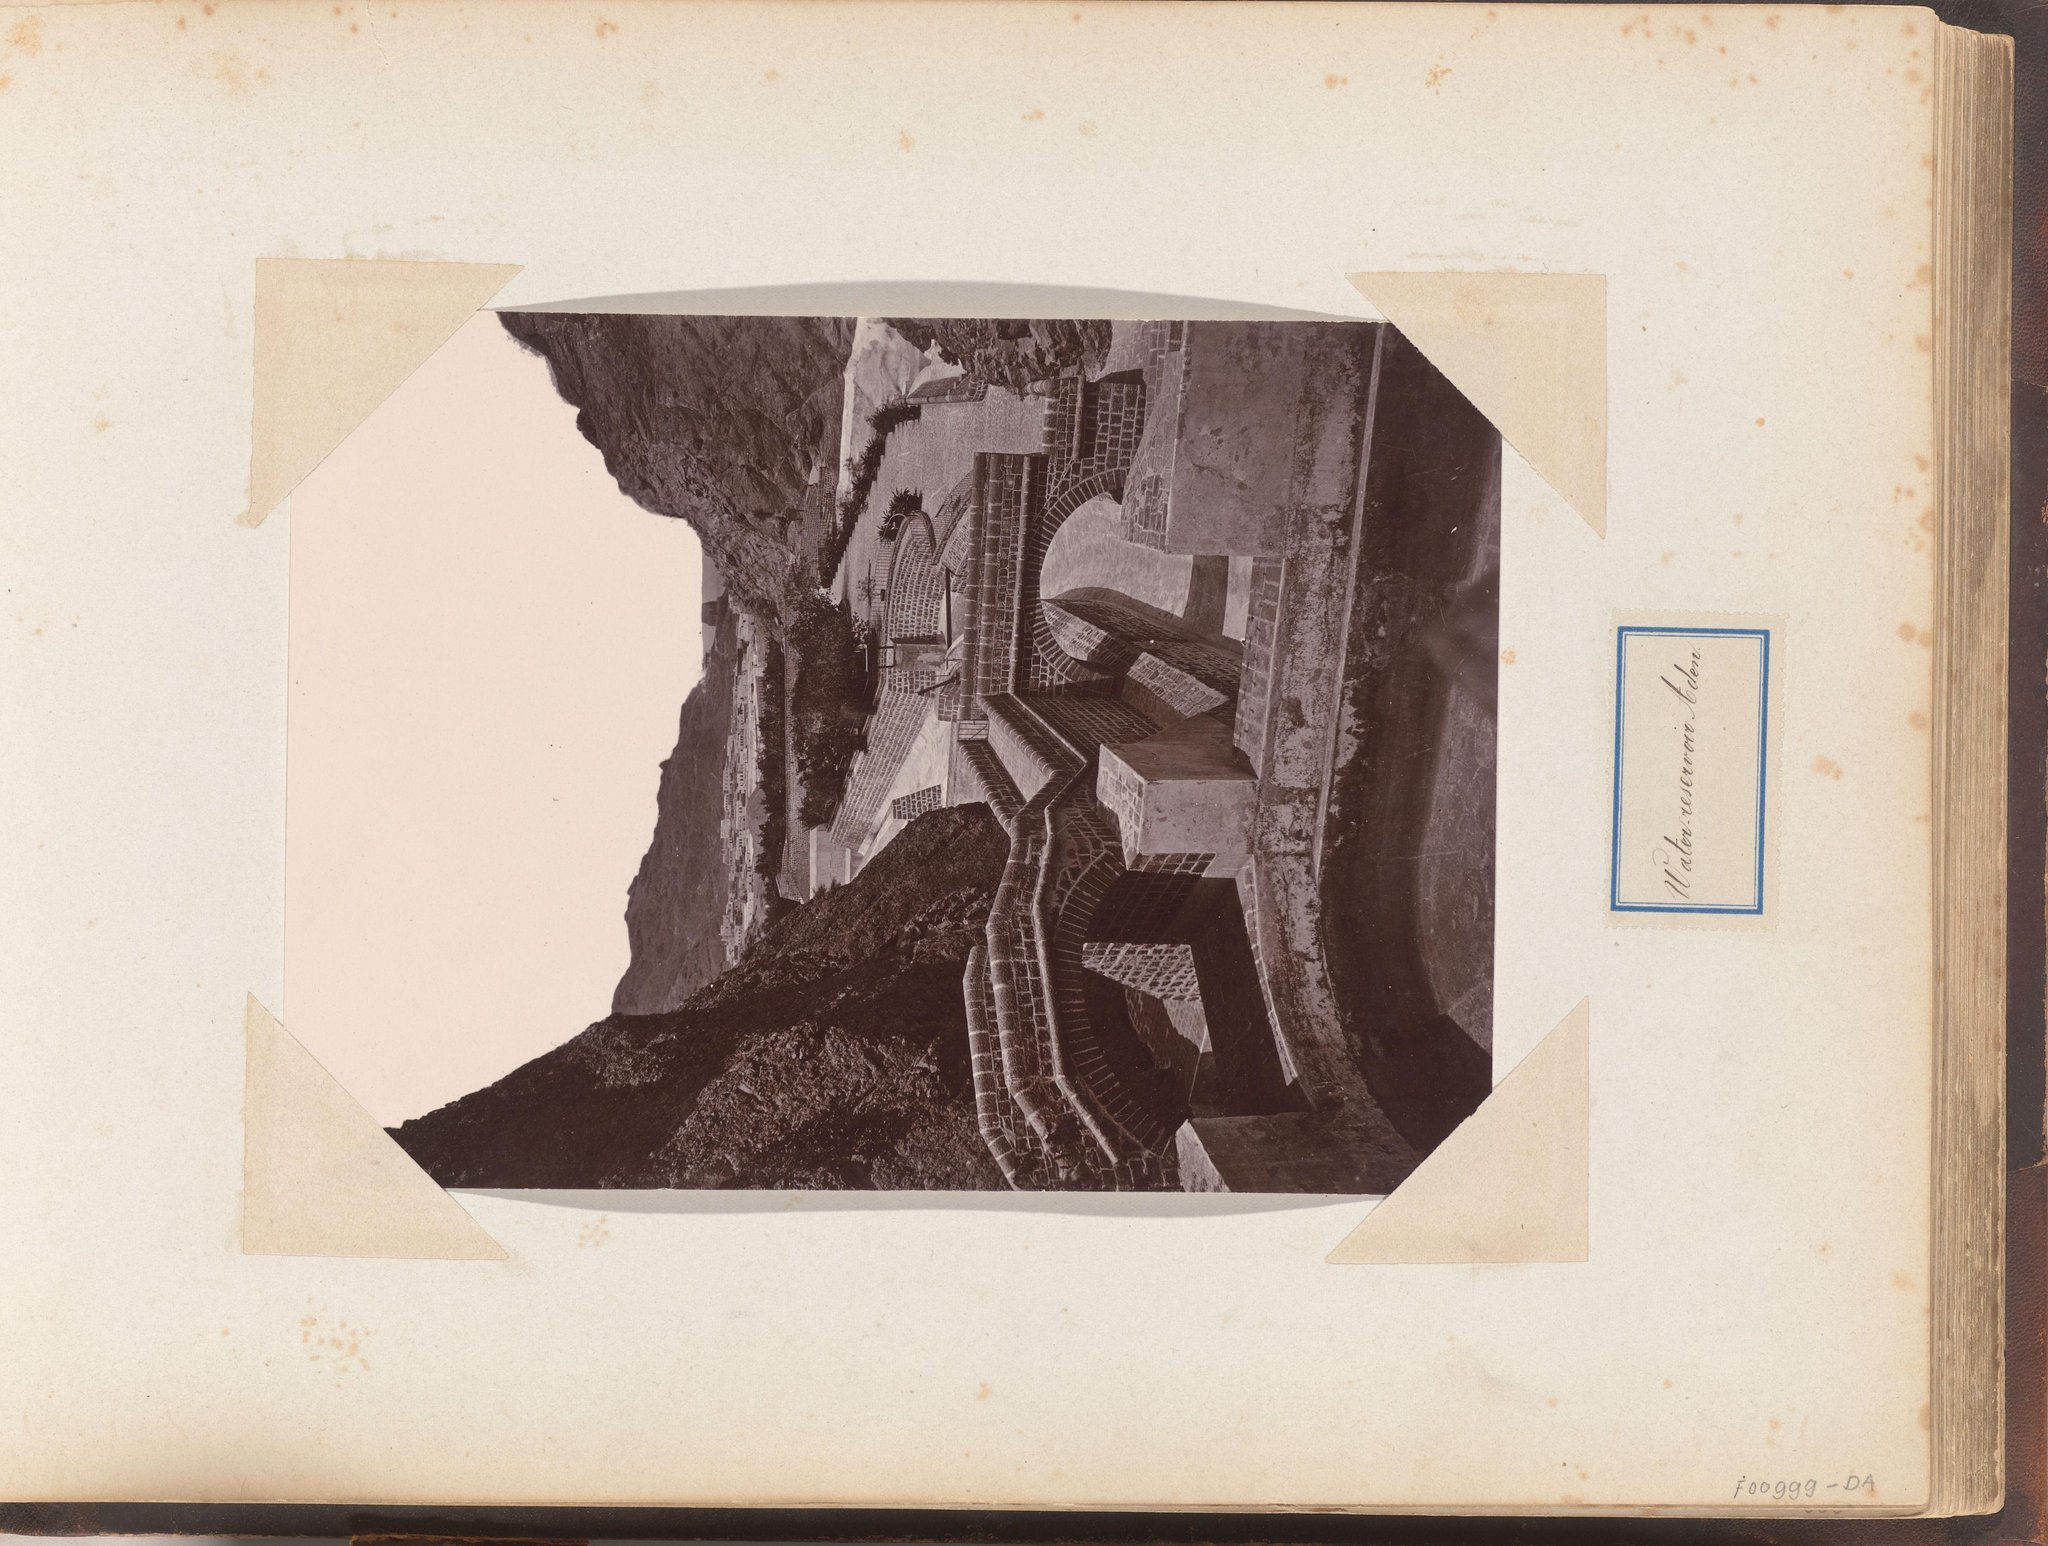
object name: photograph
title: Waterreservoir in Aden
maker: Anonymous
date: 1880-1920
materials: paper, photographic support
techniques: gelatin silver print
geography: aden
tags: water-supply (~ public services)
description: Onderdeel van Album met 191 foto's van een reis naar en door Zuid-Afrika.